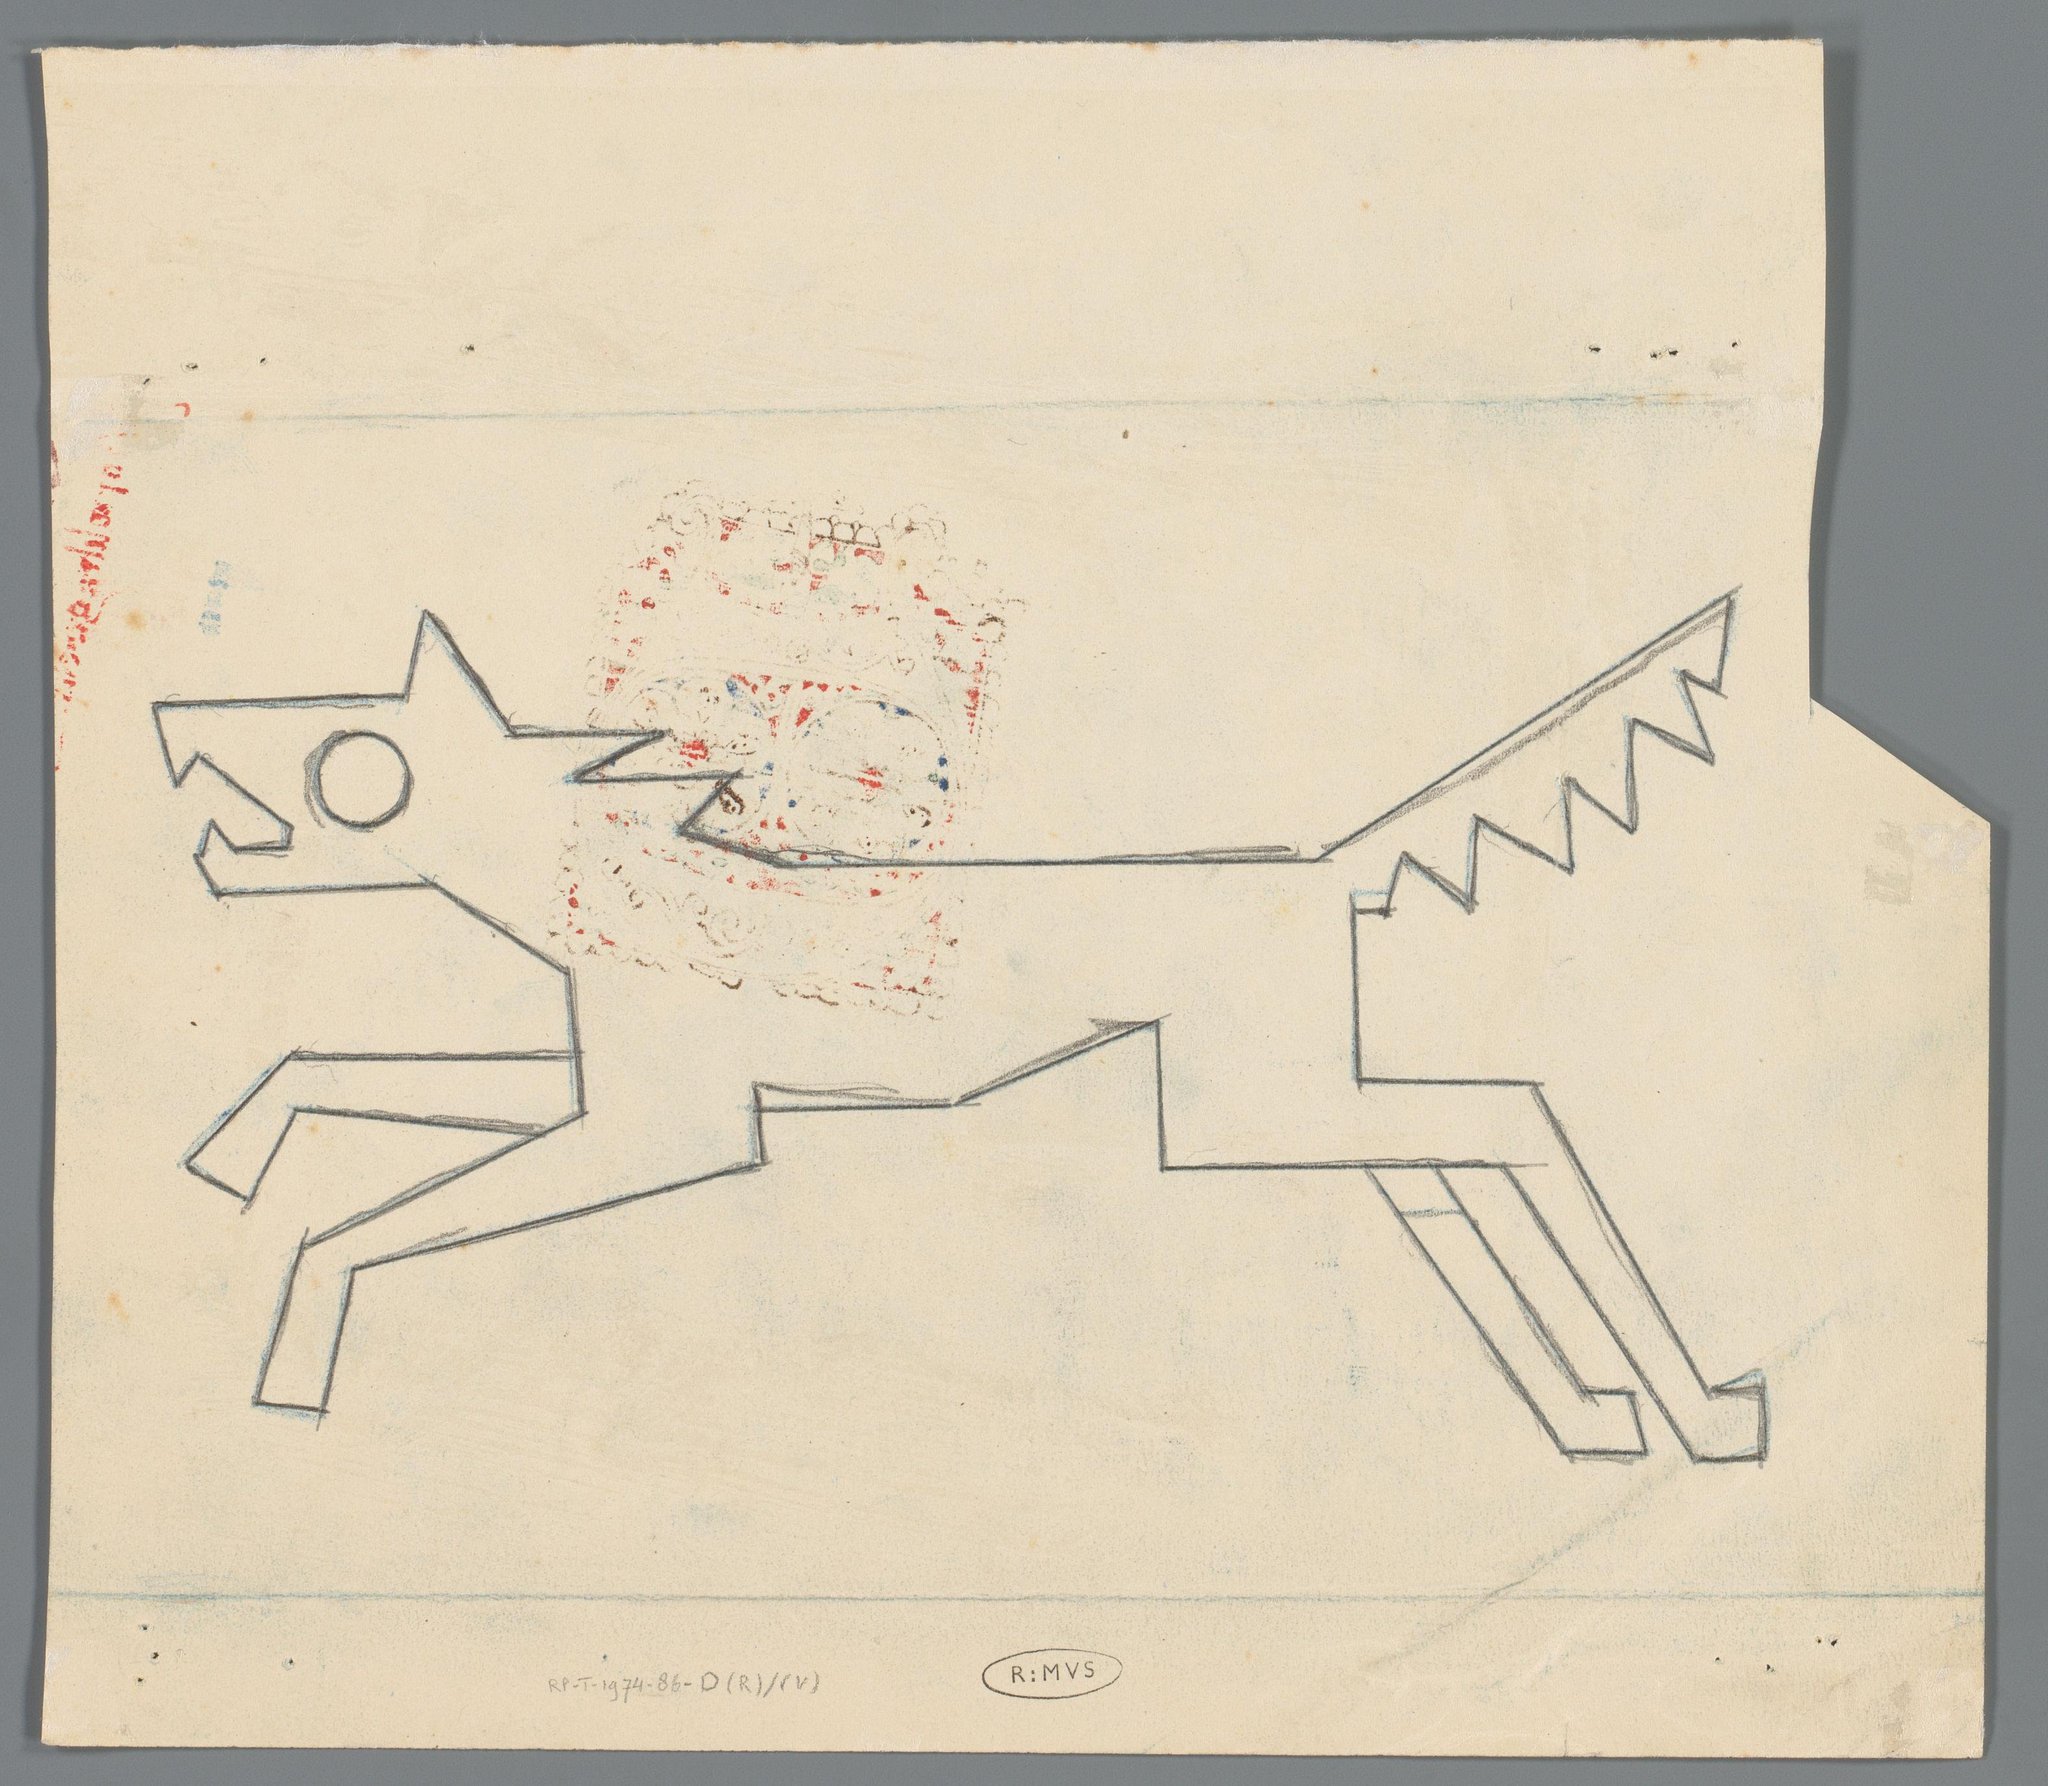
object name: drawing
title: Hond, rennend naar links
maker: gust van de wall perné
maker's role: draughtsman, painter, print maker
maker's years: 1877-1911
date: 1887-1911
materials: chalk, paper, pencil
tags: dog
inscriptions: collector's mark: Lugt 2228